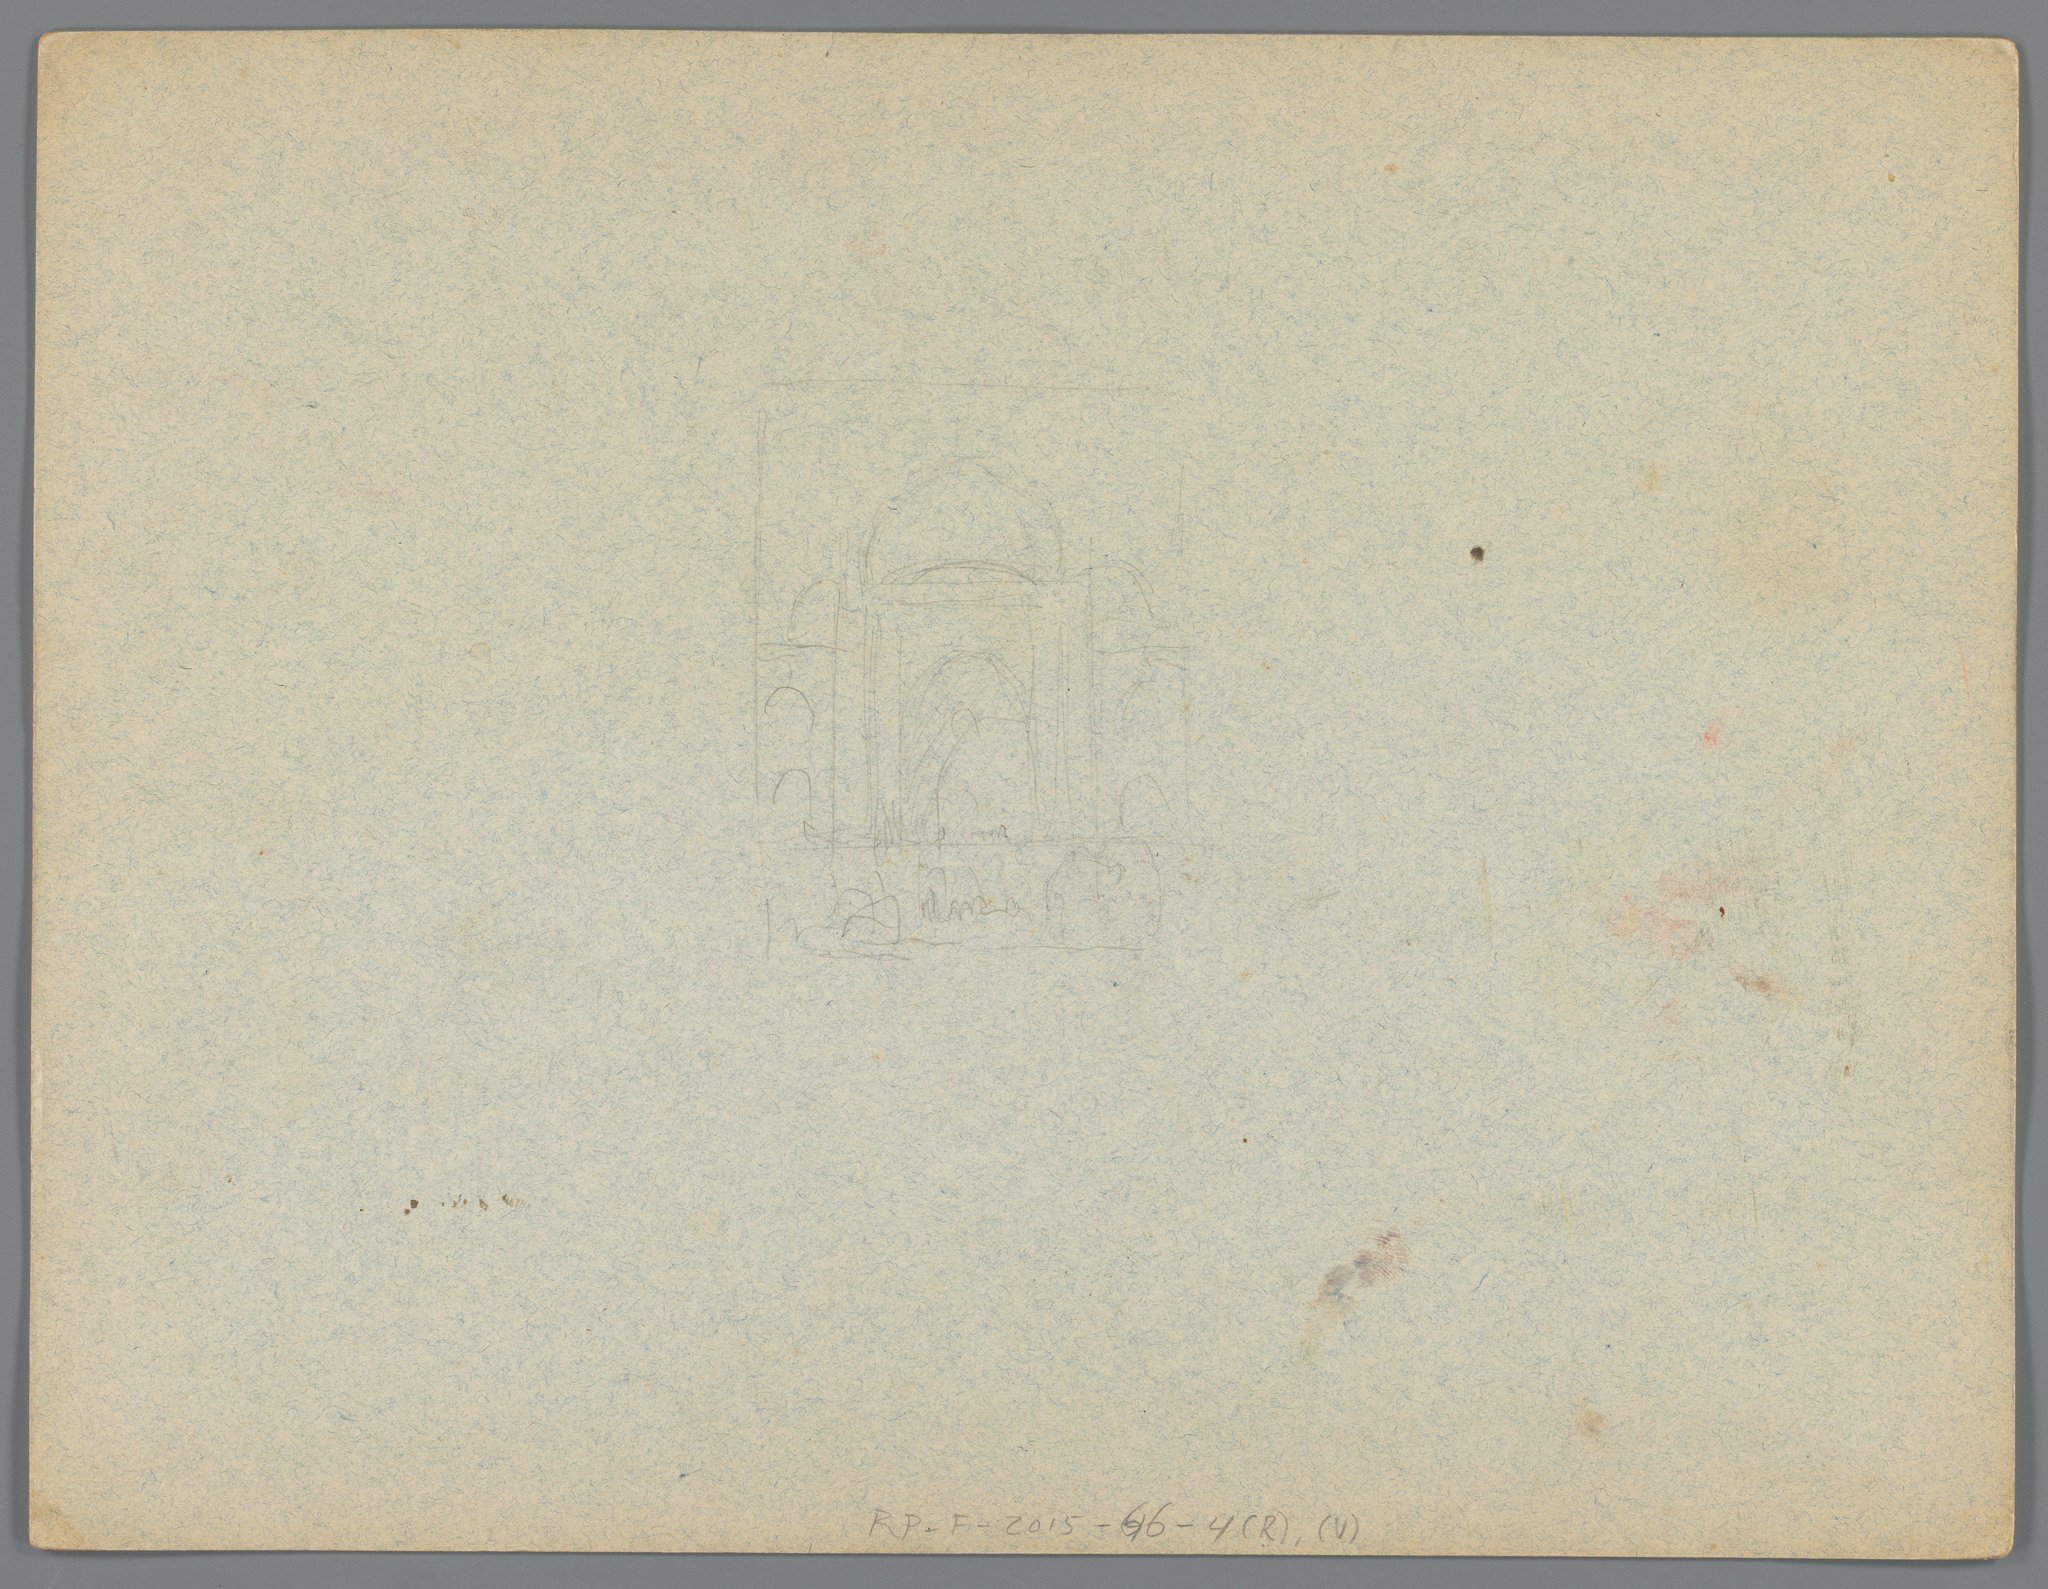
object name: drawing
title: Taj Mahal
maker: marius bauer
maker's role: draughtsman, print maker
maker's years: 1867-1932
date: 1890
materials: cardboard, pencil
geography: india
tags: palace